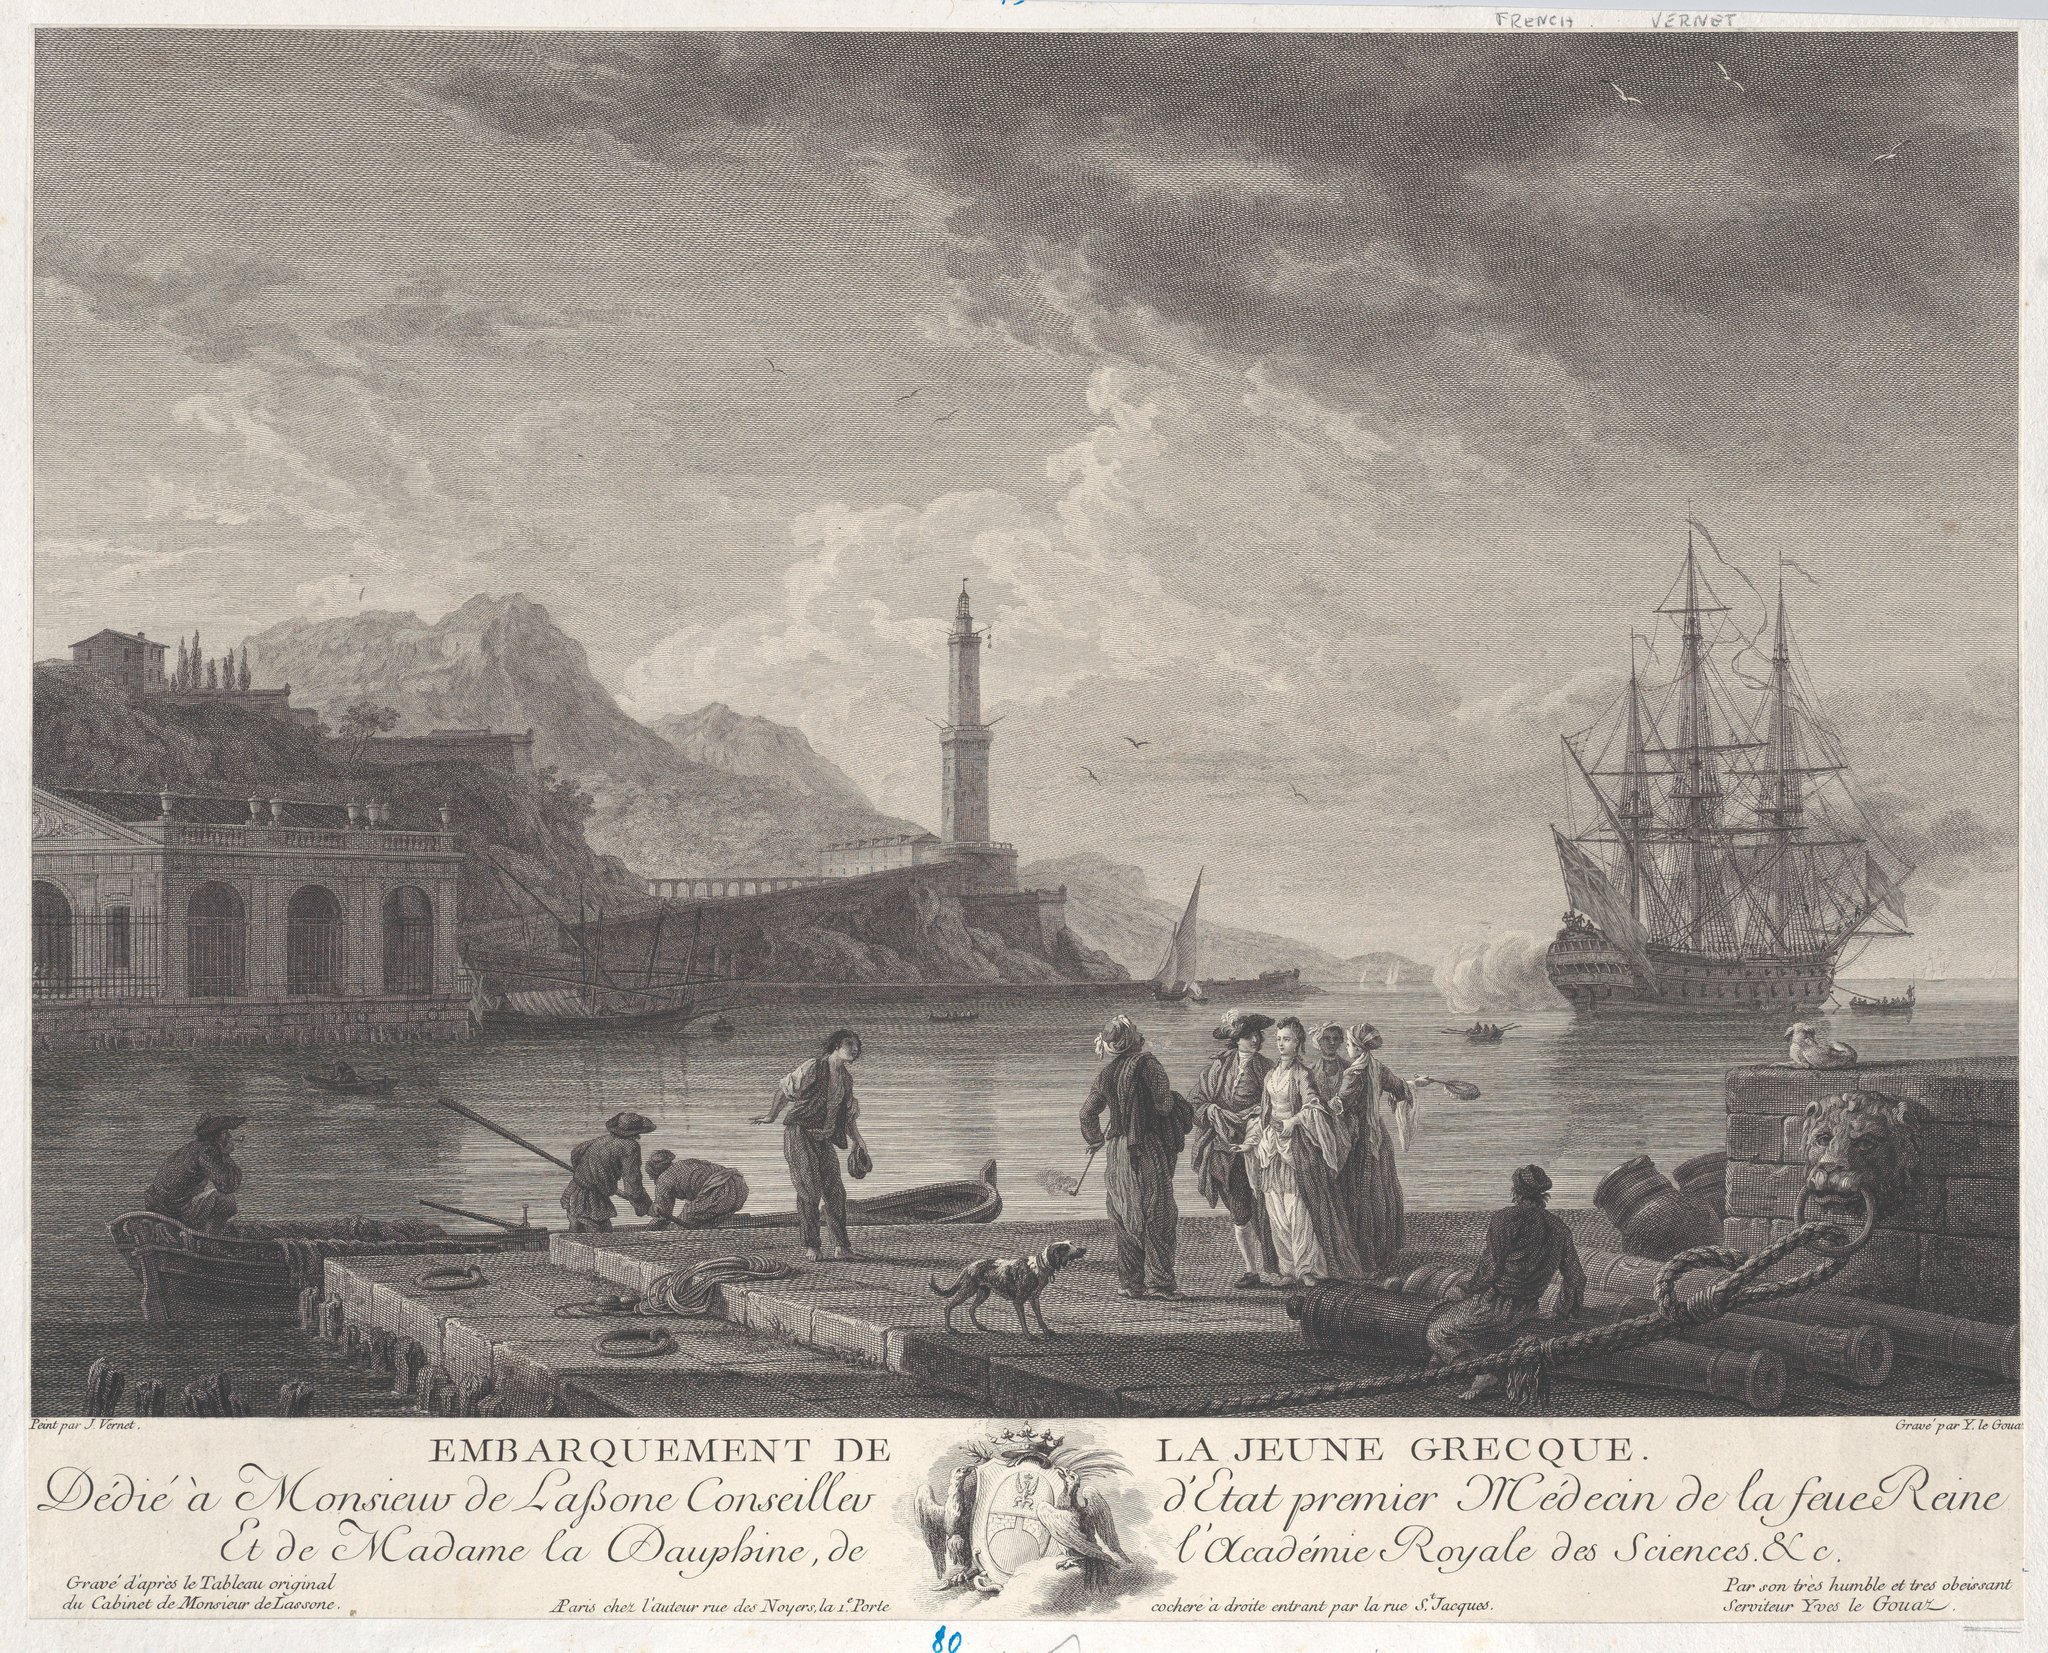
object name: print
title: Embarkation of the Young Greek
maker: joseph vernet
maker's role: artist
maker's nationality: french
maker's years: 1714-1789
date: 1771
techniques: engraving